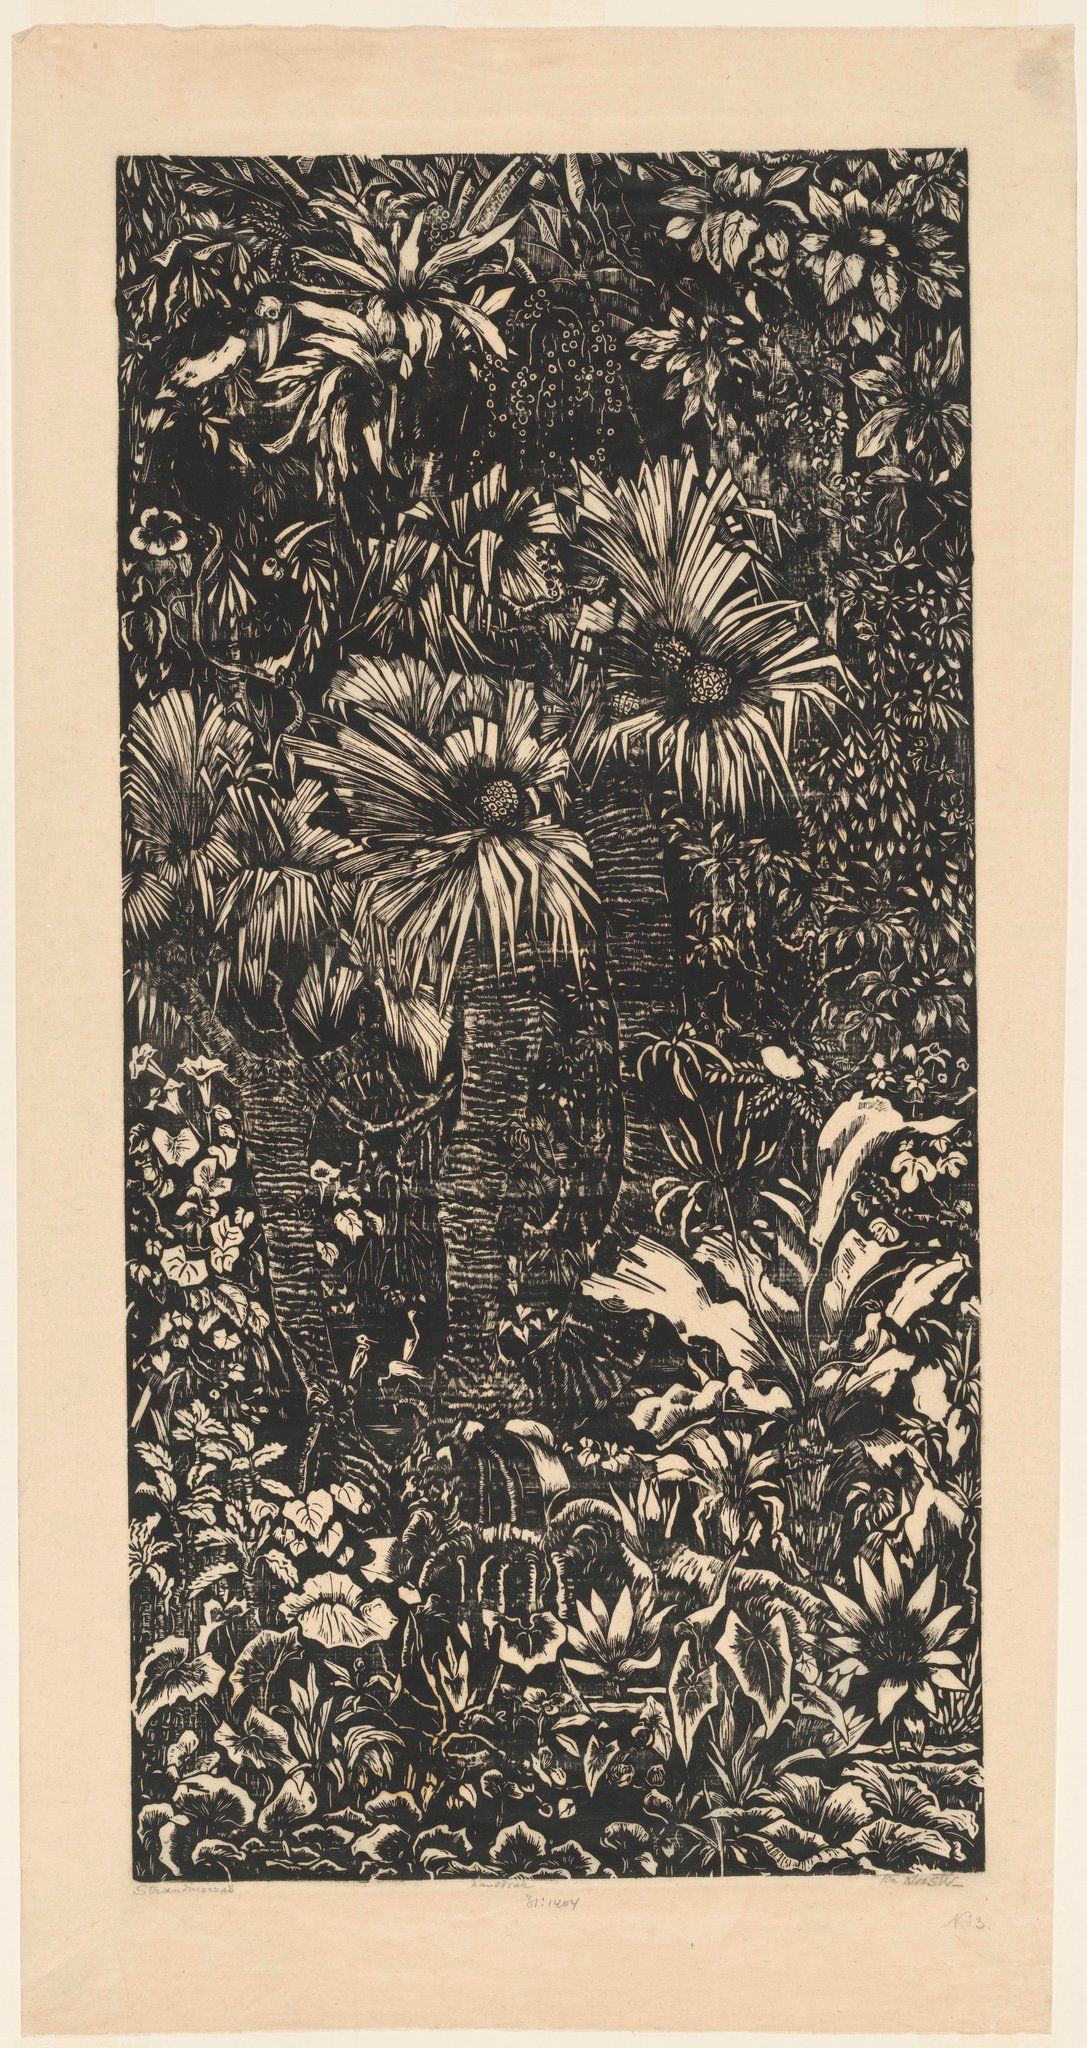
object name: print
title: Strandmoeras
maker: johannes frederik engelbert ten klooster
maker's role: draughtsman, print maker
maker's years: 1873-1940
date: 1883-1931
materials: paper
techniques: woodcut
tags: swamp, inland marsh, fens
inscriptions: number: ‘No 3.’